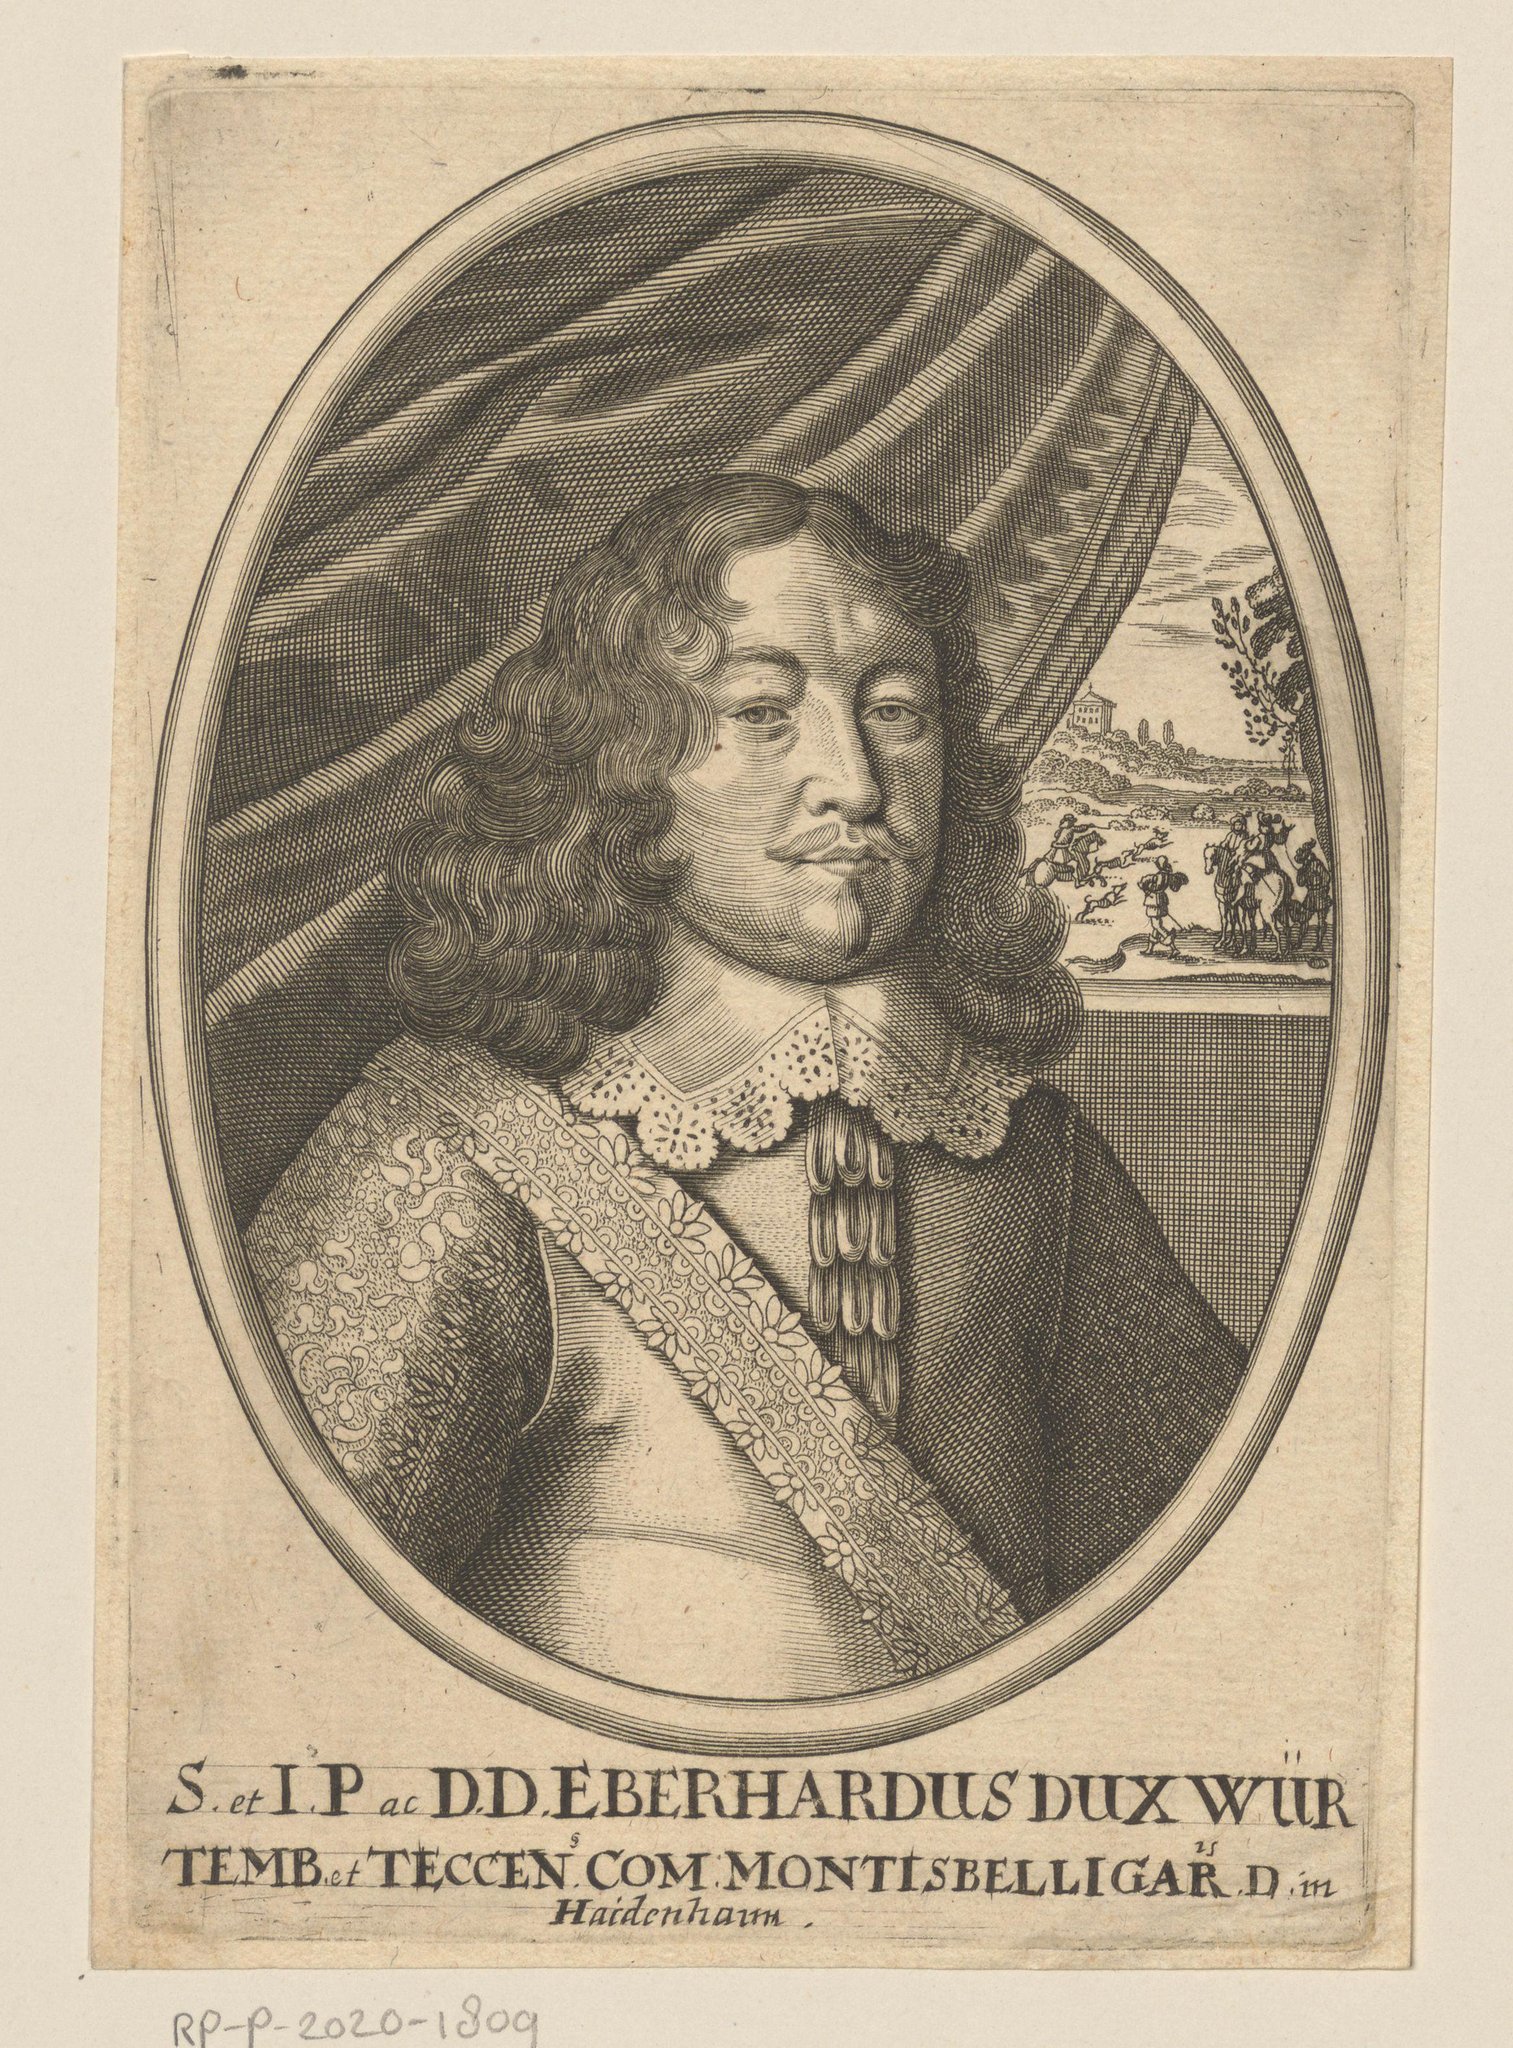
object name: print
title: Portret van Eberhard III von Württemberg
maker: Anonymous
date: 1640-1700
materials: paper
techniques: engraving, etching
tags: eberhard von württemberg (iii), historical persons